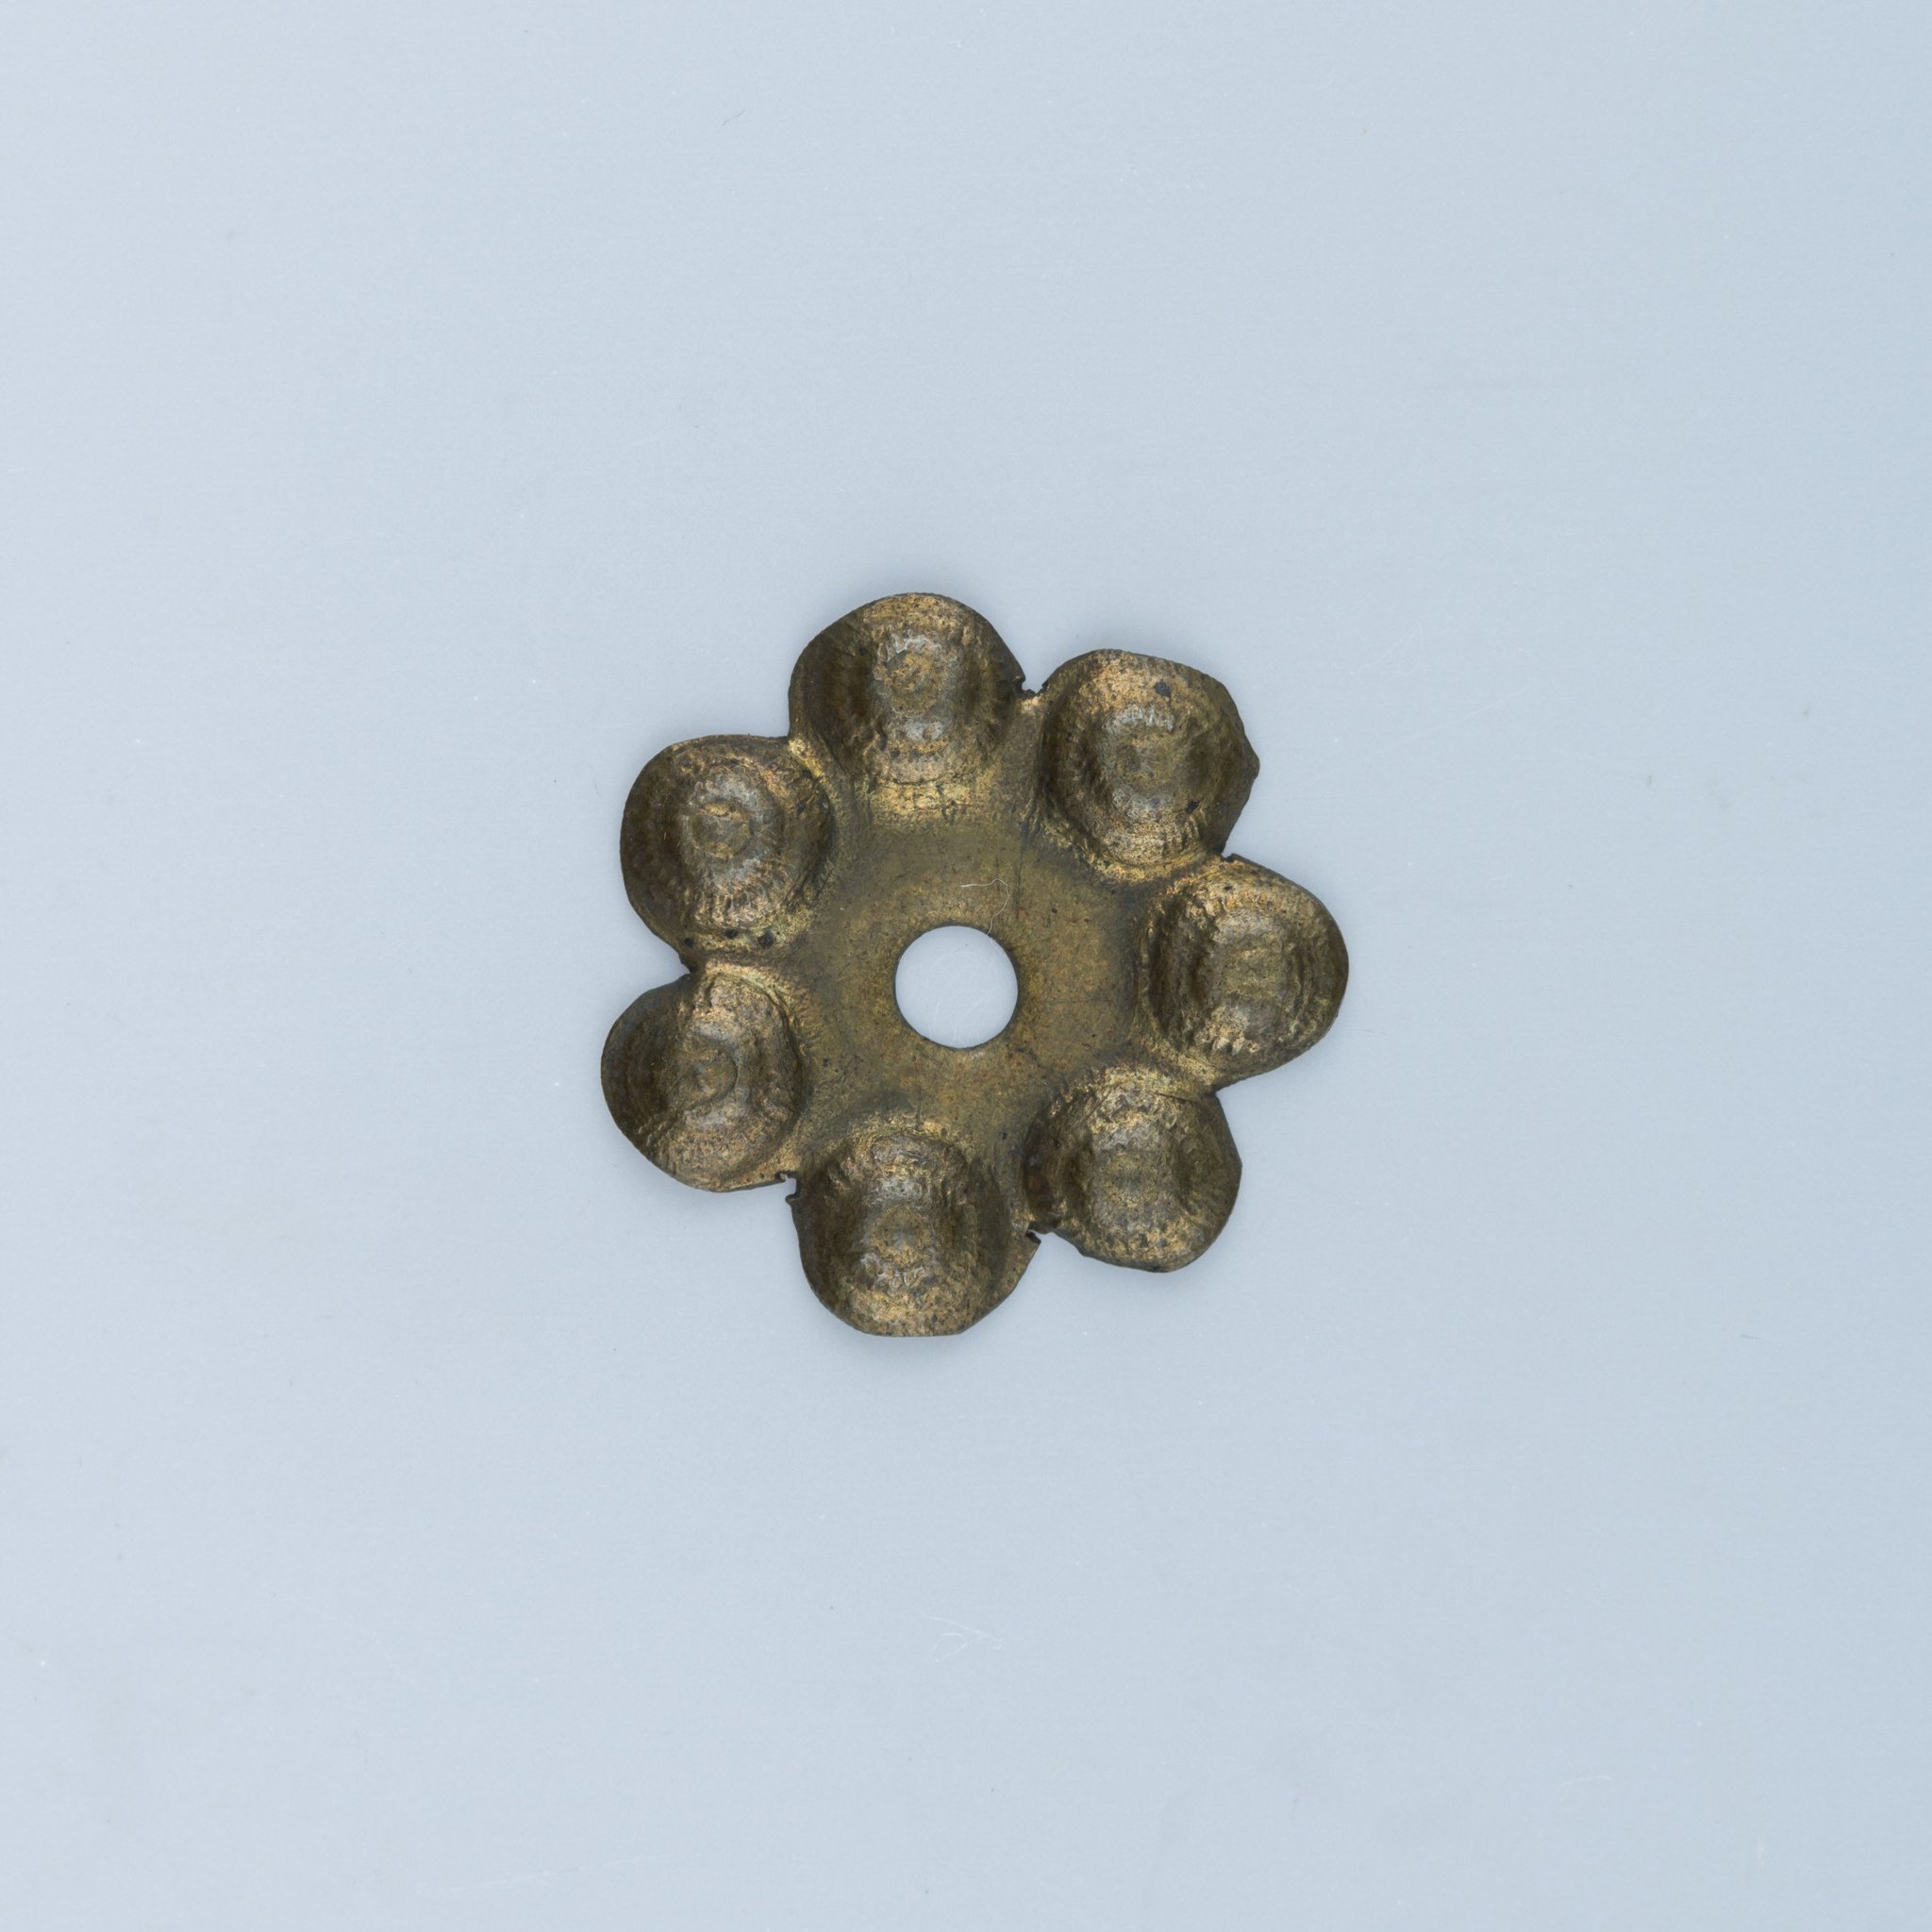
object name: rosette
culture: french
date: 1540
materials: brass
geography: france